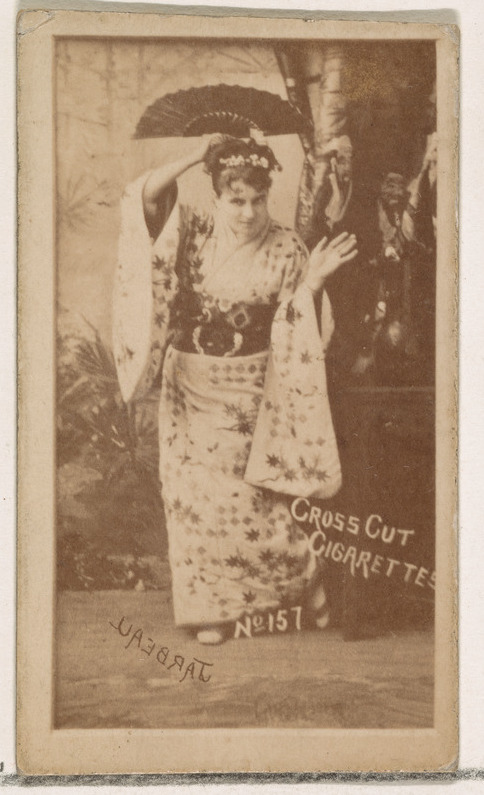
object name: print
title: Card Number 157, Jarbeau, from the Actors and Actresses series (N145-1) issued by Duke Sons & Co. to promote Cross Cut Cigarettes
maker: w. duke, sons & co.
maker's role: publisher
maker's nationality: american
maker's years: 1870-1920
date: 1880-1889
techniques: albumen silver print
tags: portraits,women,actresses